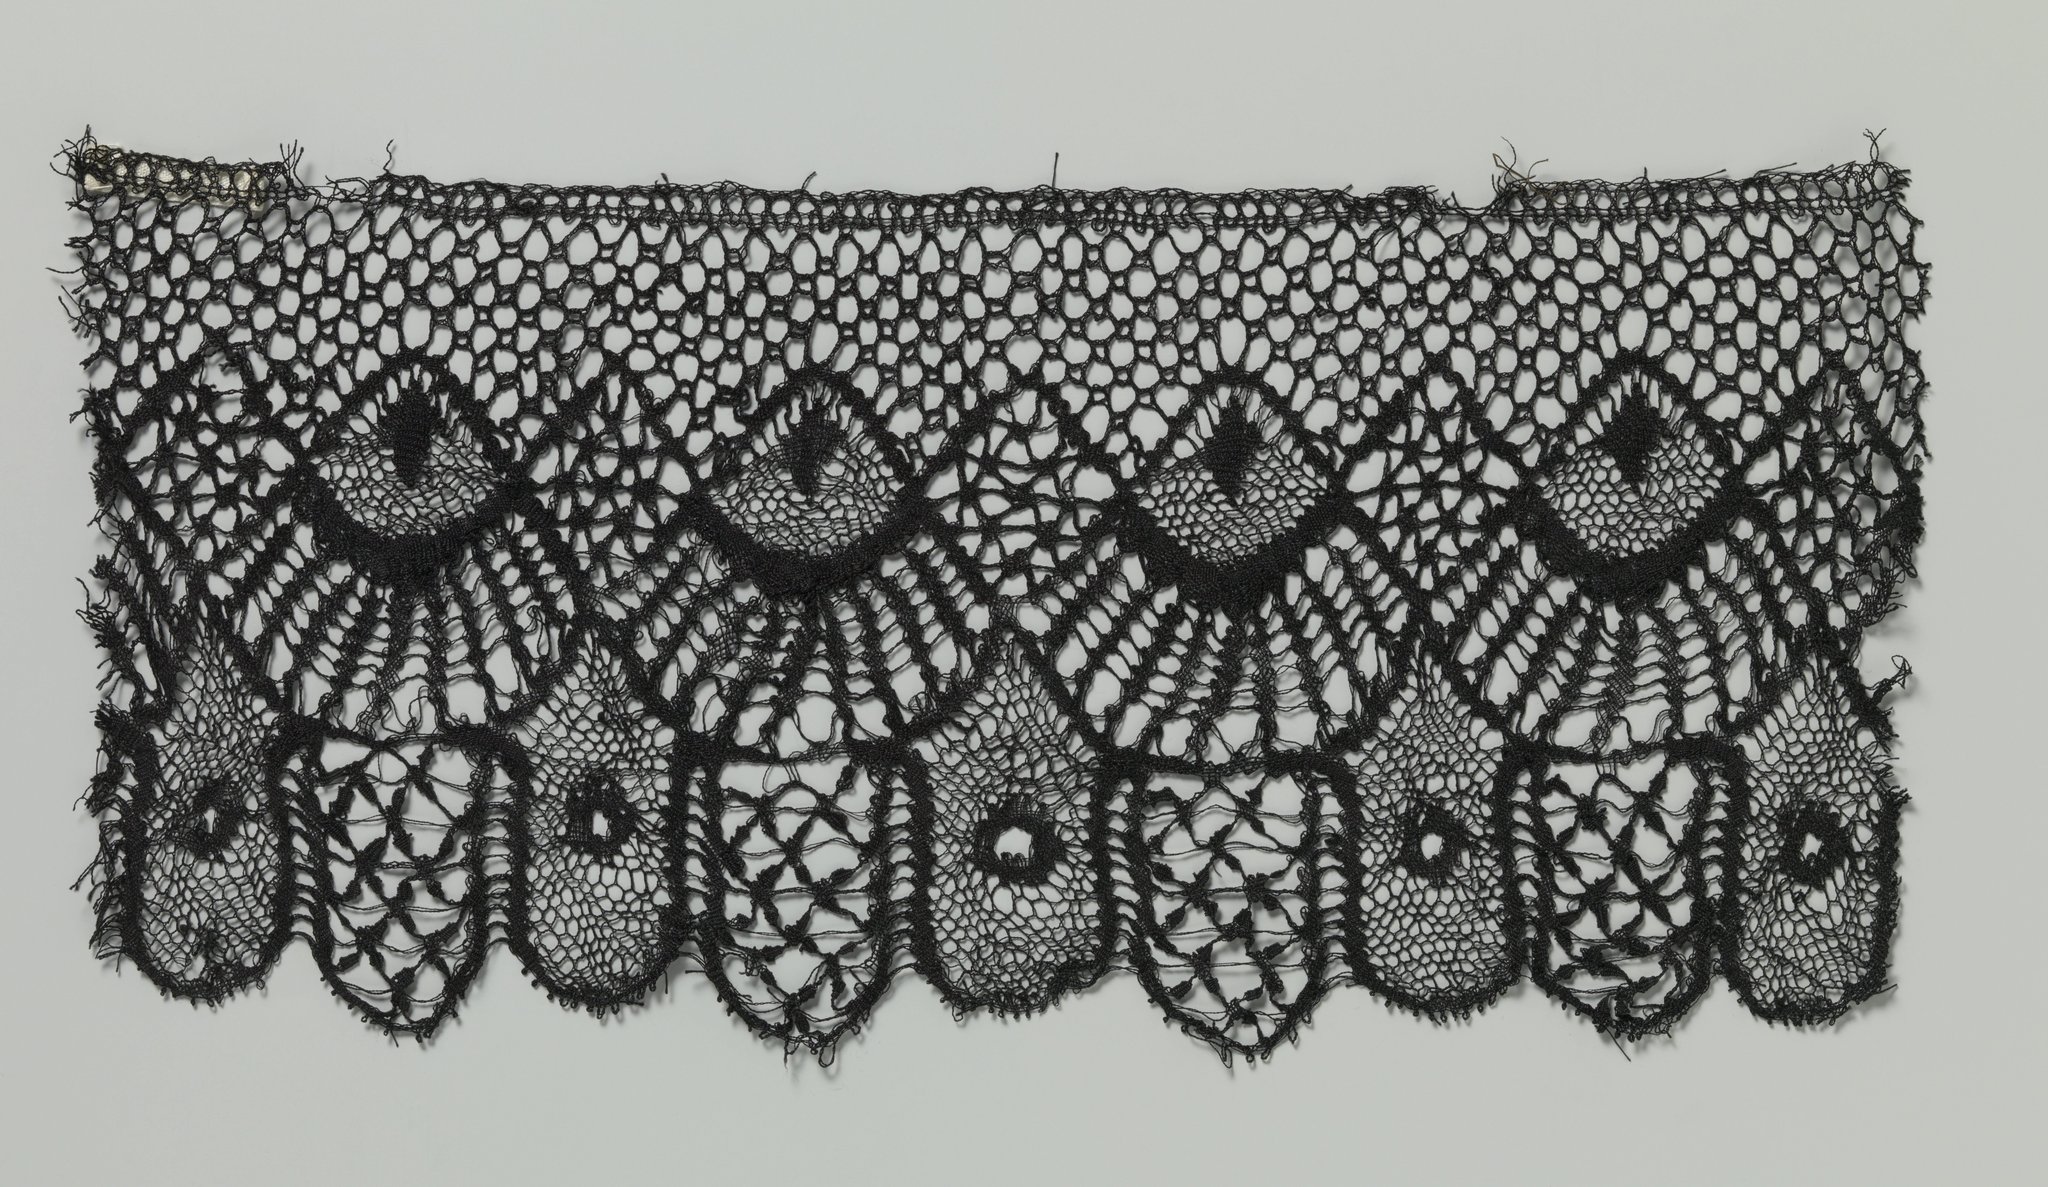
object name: strip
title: Strook kloskant met drie lange lobben onder hangende waaiers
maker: Anonymous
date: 1850-1899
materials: silk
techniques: lace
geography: le puy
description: Strook zwarte kloskant: Le Puy-kant. Het zich herhalende patroon bestaat uit aaneengeschakelde hangende waaiers. De ruimte boven de punten waar de waaiers elkaar raken wordt gevuld door een ruit. Onder elke waaier hangen drie halfovaalvormige lobben, waarbij de twee buitenste gedeeld worden met de voorgaande of volgende waaier. Aan de bovenzijde van de strook zijn de motieven met elkaar verbonden door een grove siergrond. In de lobben recht onder de waaiers is een siergrond toegepast, versierd met motiefjes gemaakt in vormslag. De bovenzijde van de strook is recht afgewerkt. De schulpenrand langs de onderzijde van de strook komt voort uit de halfovaalvormige lobben en is afgewerkt met picots.